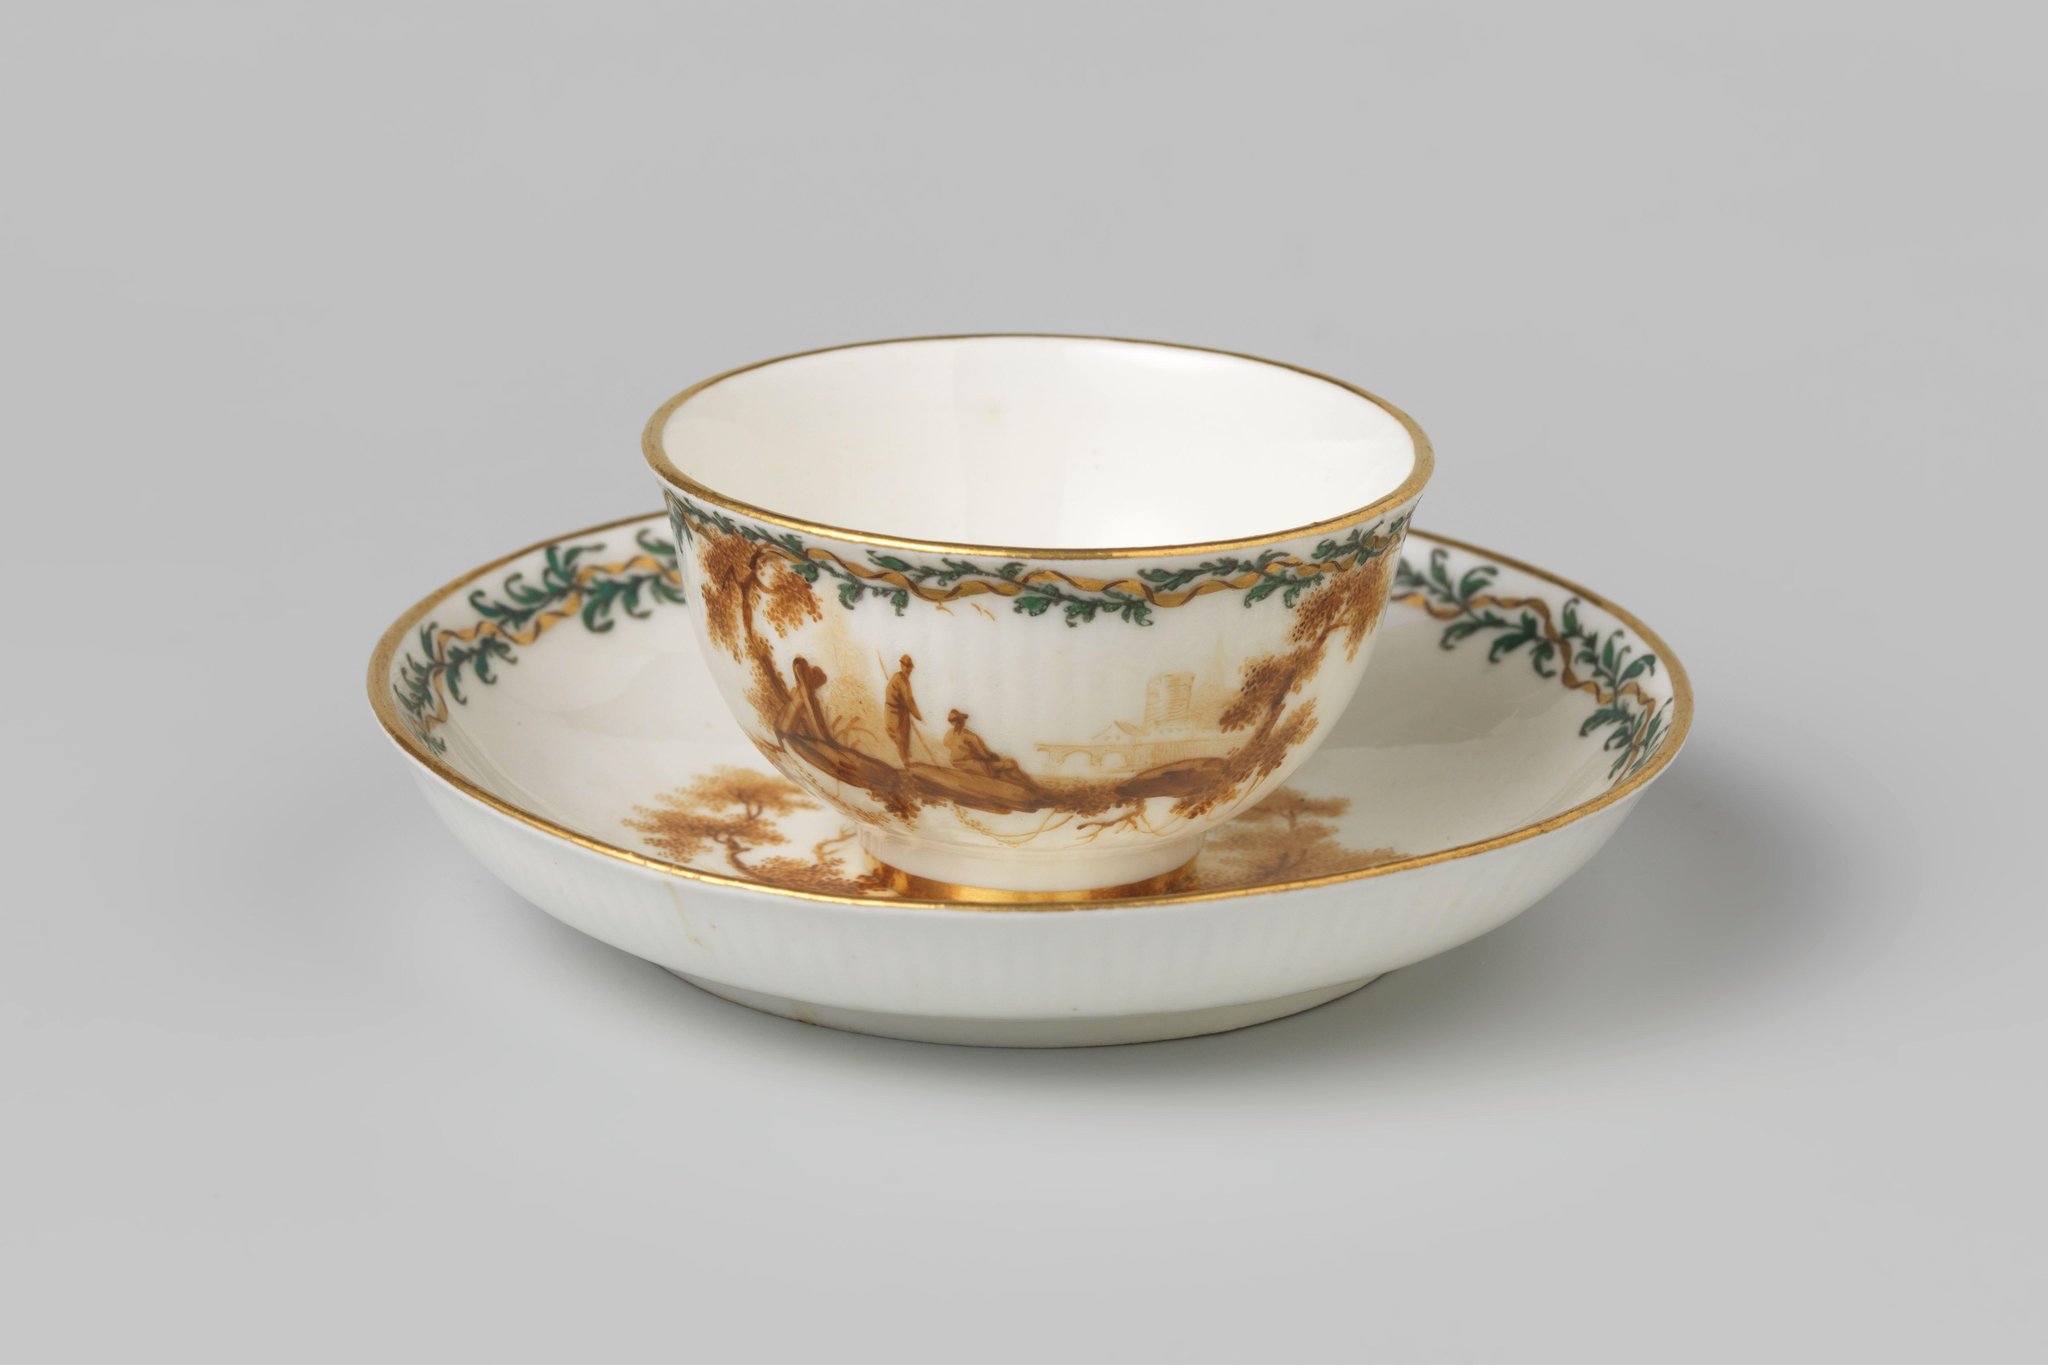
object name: kop en schotel, kop en schotel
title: Kop, beschilderd met figuren in landschappen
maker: fidelle duvivier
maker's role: porseleinschilder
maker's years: 1740-1817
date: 1778-1782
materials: porcelain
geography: loosdrecht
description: Kop van porselein. Kop zonder oor. Beschilderd in sepia met figuren in een landschap. Op de achterkant van de kop een grondje. Langs de randen een kronkelend lint in goud en bruin, waaromheen zich een groene bladtak slingert. De buitenwand van de kop en de achterkant van de schotelrand is versierd met twee rijen verspringende ribben. Gouden biezen langs voet- en mondrand van de kop en langs de schotelrand.